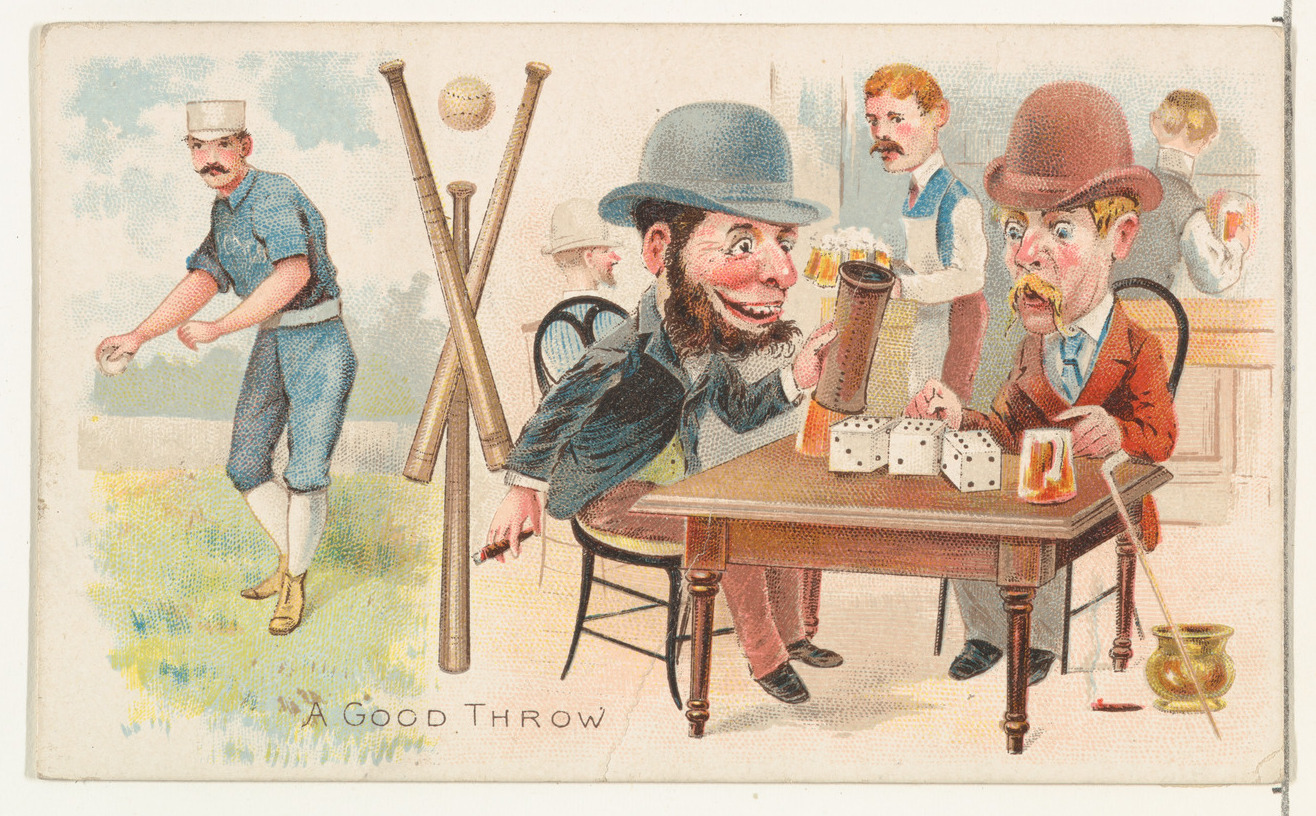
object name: print, baseball card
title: A Good Throw, from the Talk of the Diamond set (N135) issued by Duke Sons & Co., a branch of the American Tobacco Company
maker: w. duke, sons & co.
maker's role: publisher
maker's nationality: american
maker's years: 1870-1920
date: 1888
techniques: color lithograph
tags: men,dice,playing,baseball,athletes